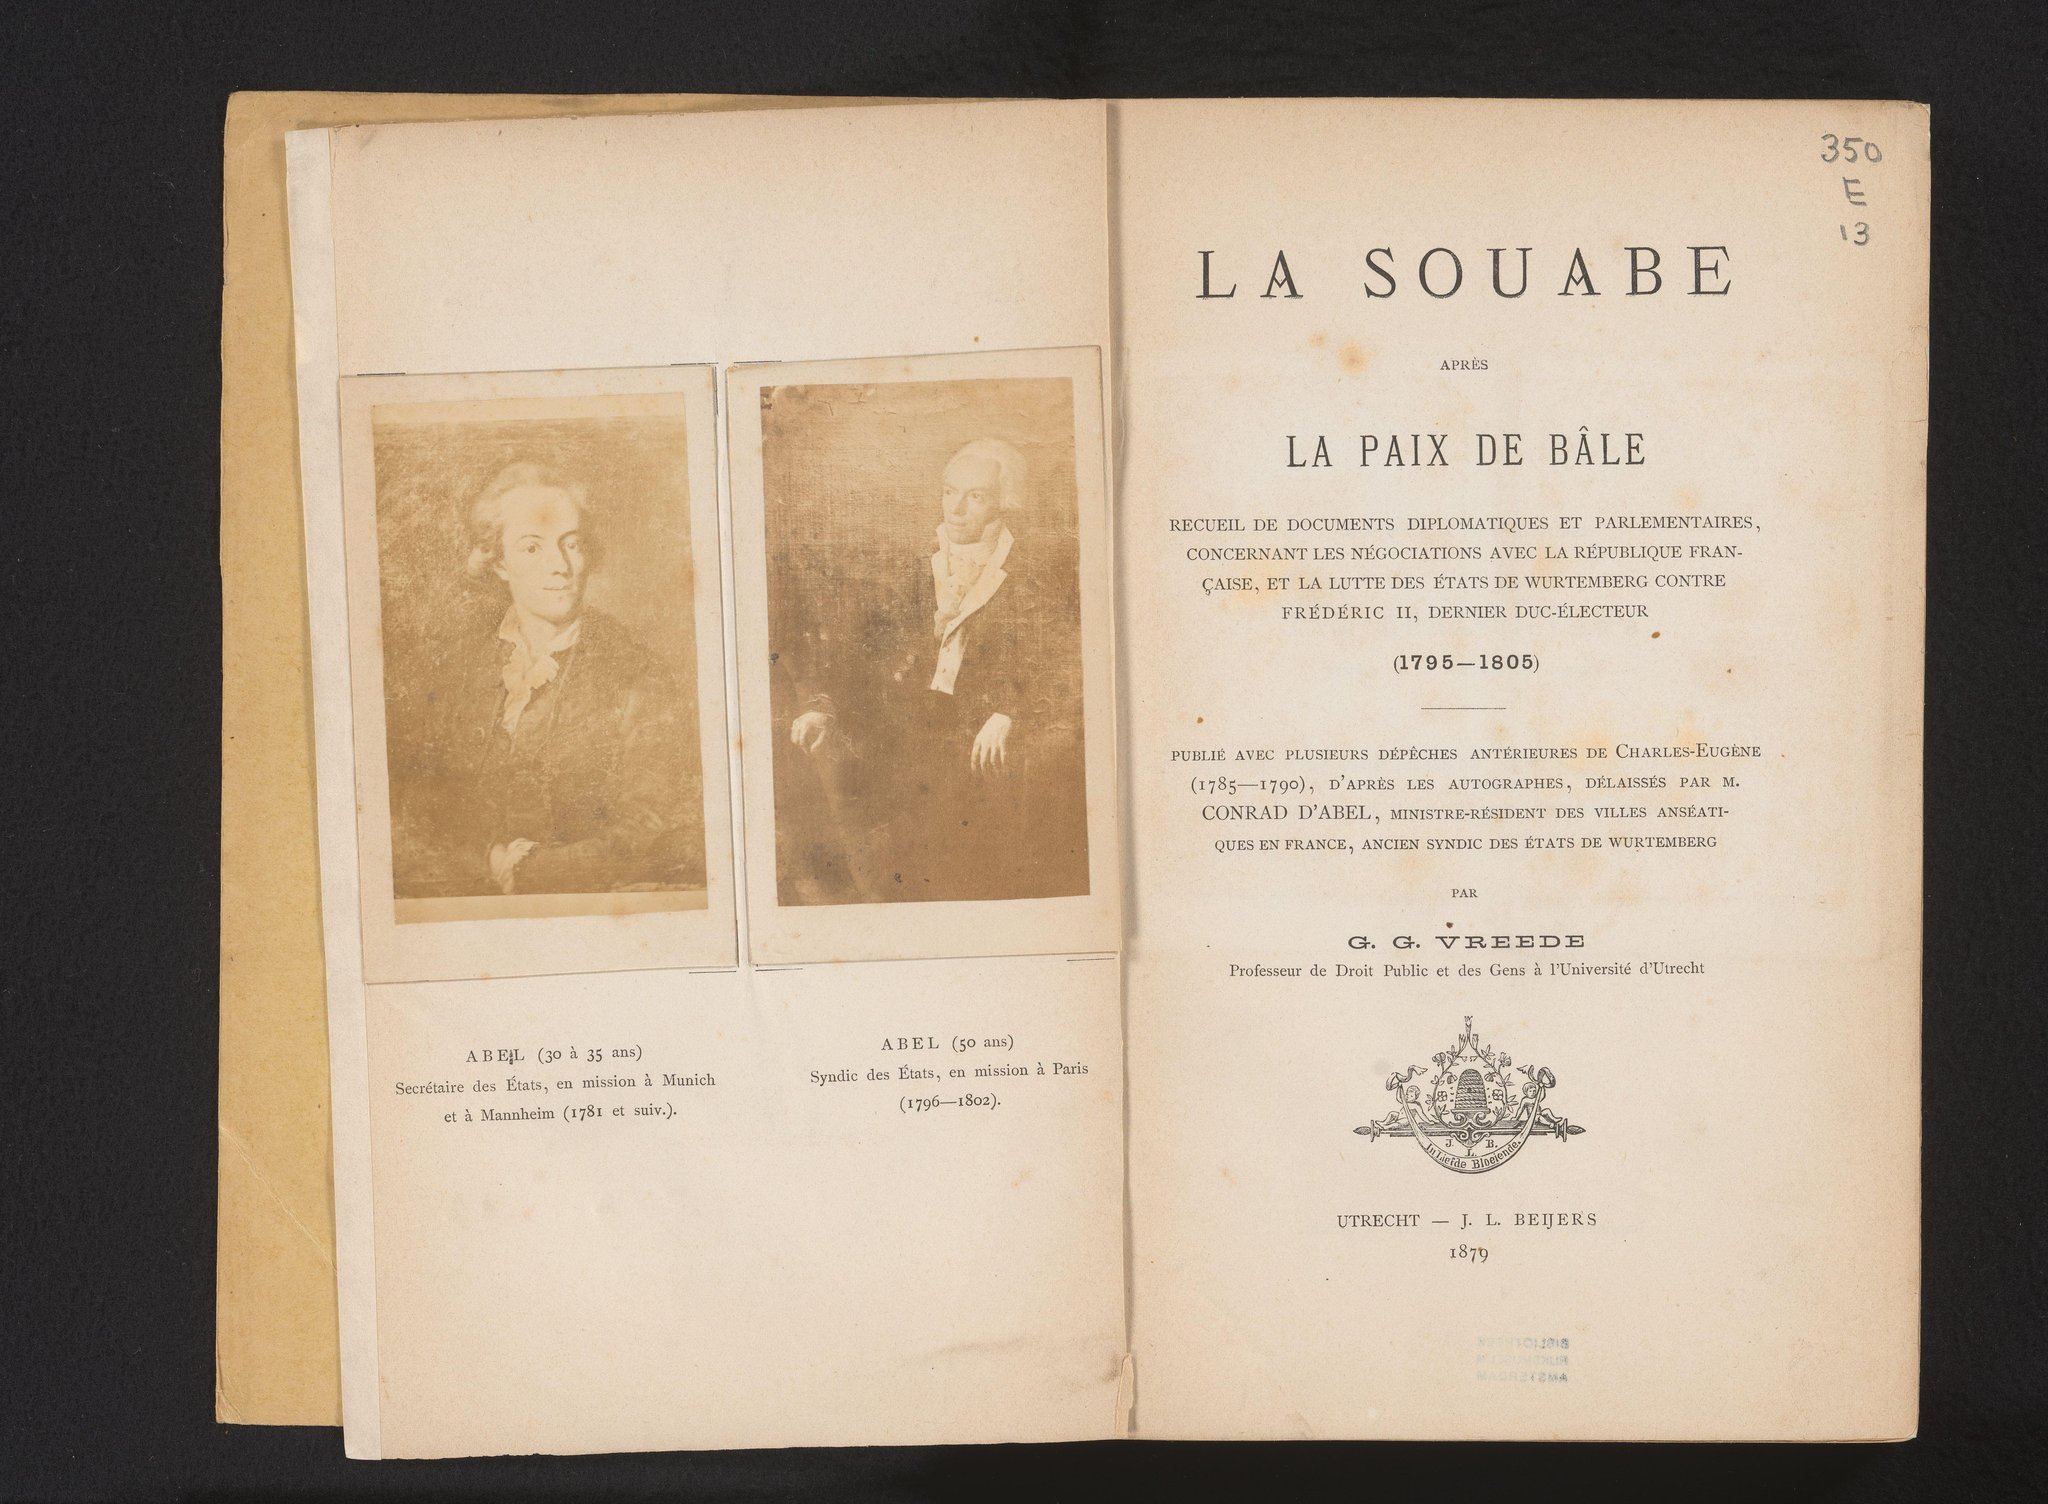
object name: carte de visite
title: Fotoreproductie van een schilderij van Conrad Abel, staatssecretaris op missie te München en Mannheim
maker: Anonymous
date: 1871-1879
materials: paper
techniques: albumen print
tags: politician, e.g. party leader, picture, painting